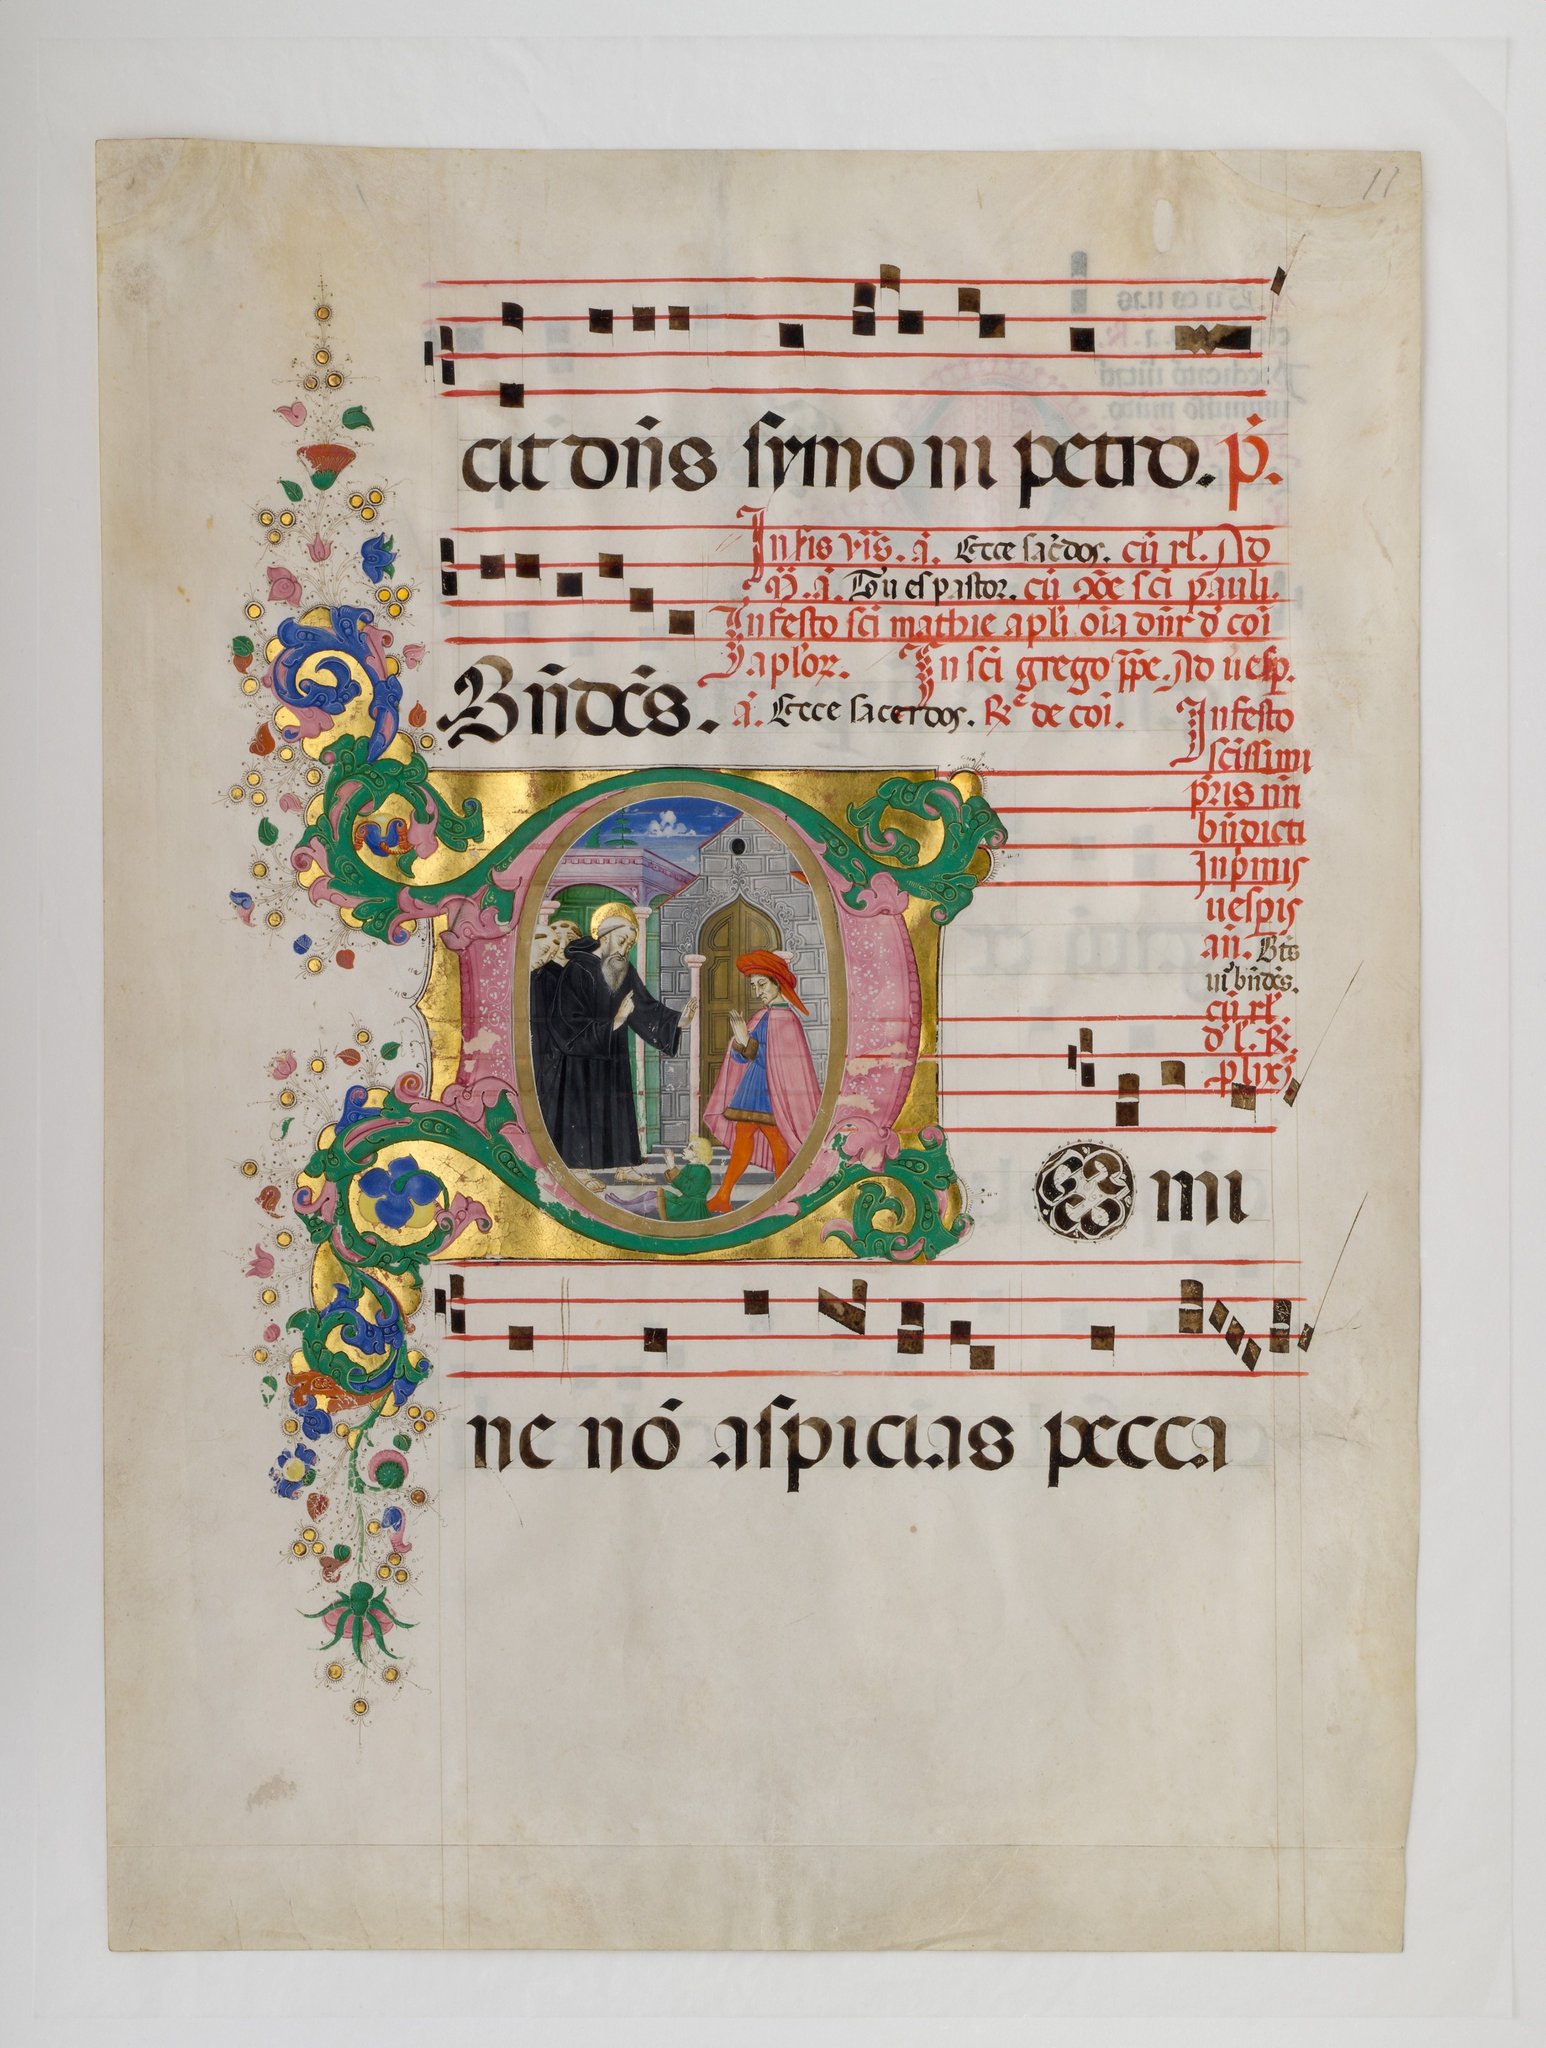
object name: antiphonary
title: Manuscript Leaf with Saint Benedict Resuscitating a Boy in an Initial D, from an Antiphonary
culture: italian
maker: master of the riccardiana lactantius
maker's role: artist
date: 1451-1500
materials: gold, ink, parchment, paint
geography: italy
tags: boys,saints